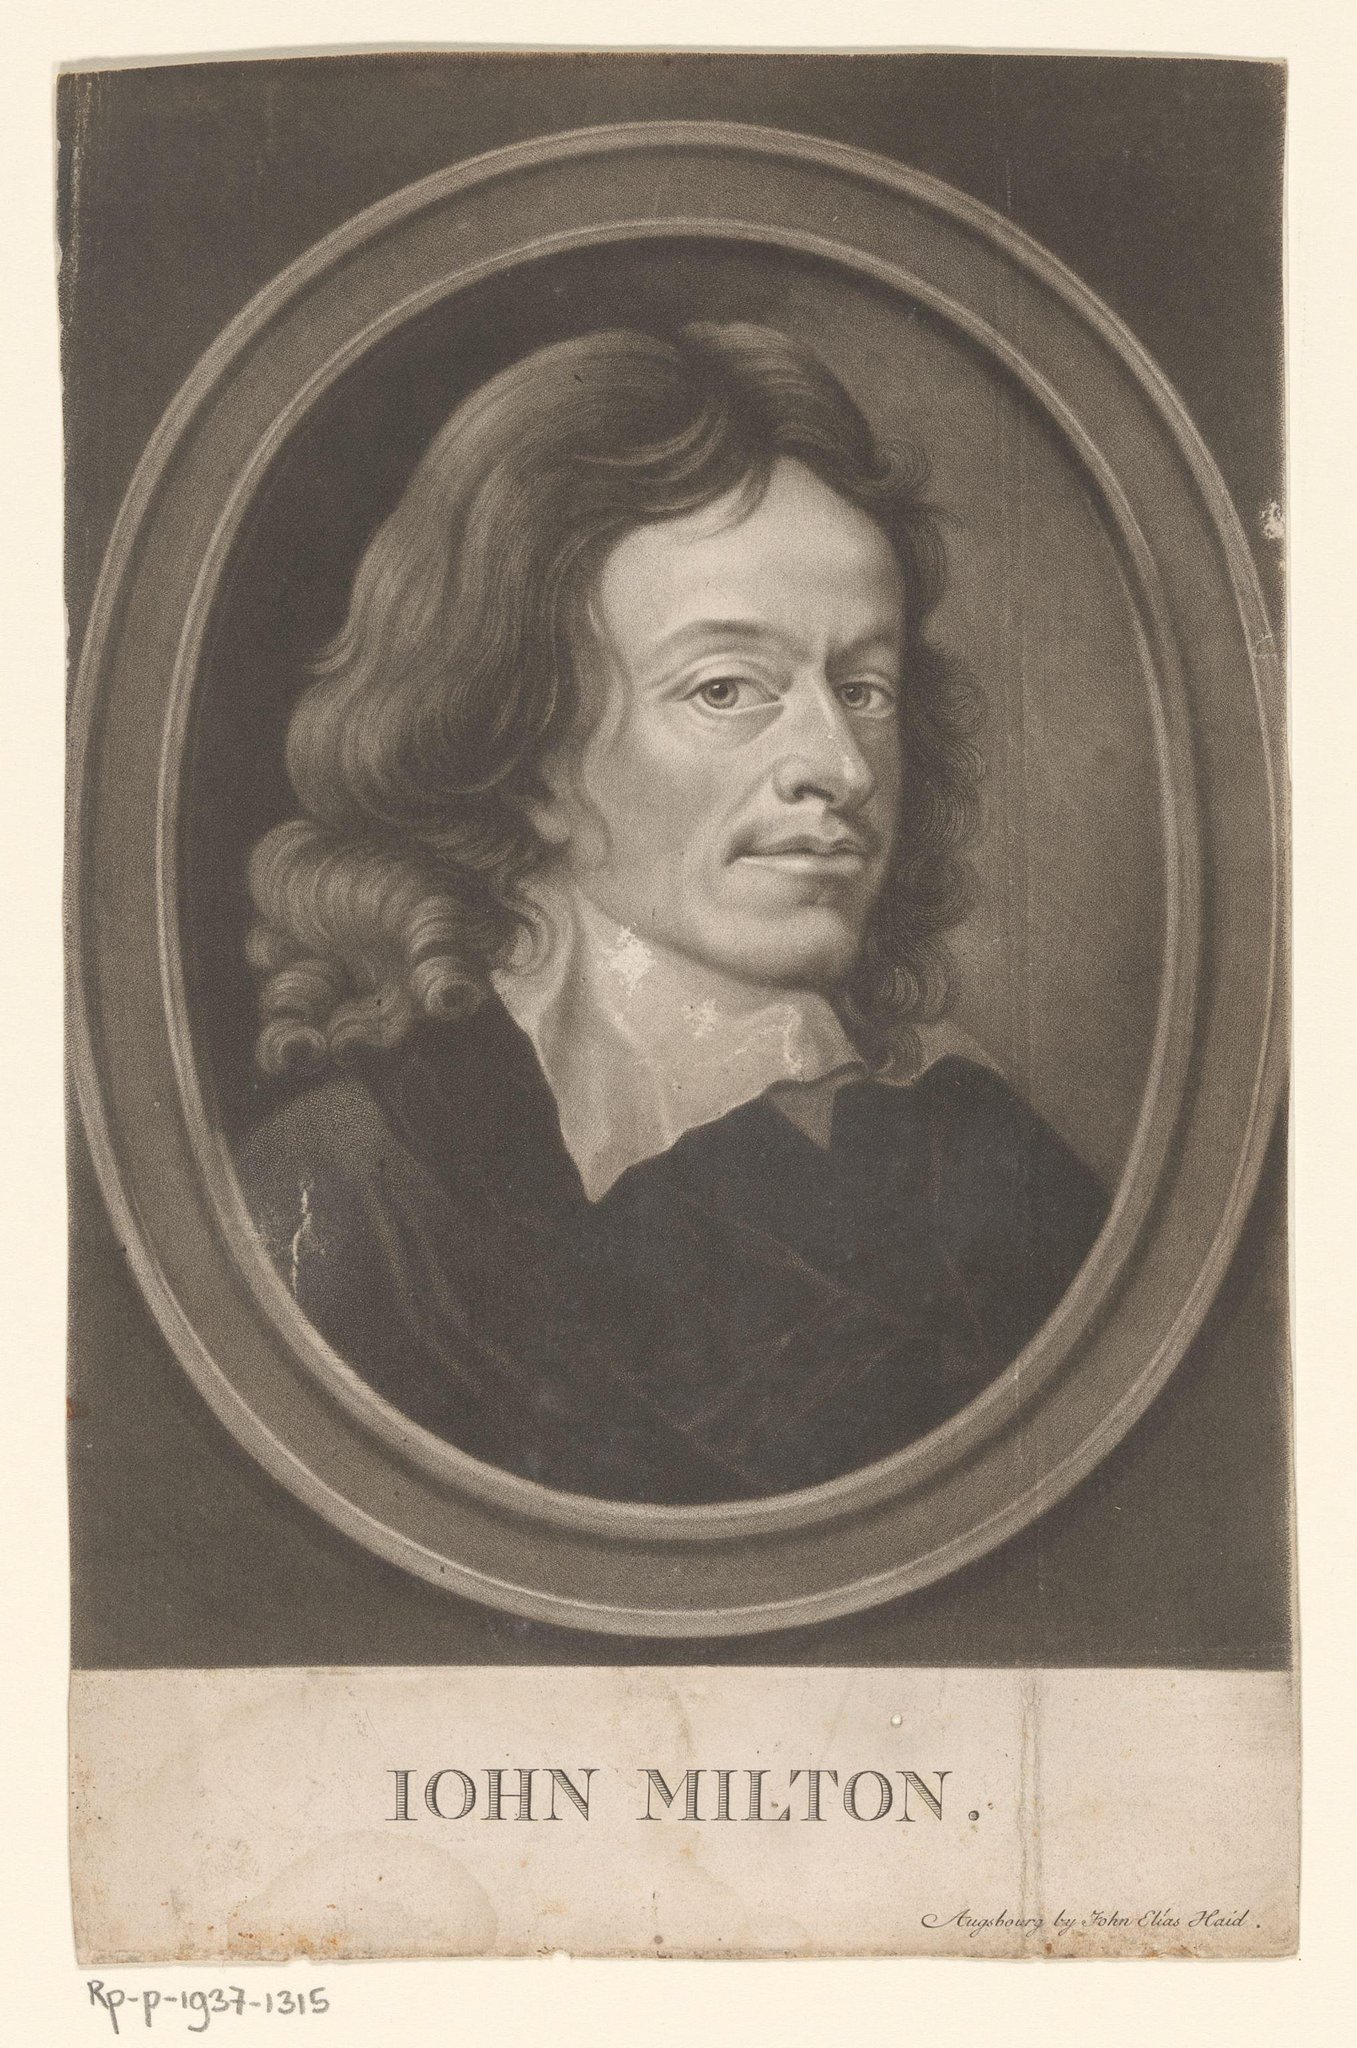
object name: print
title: Portret van John Hilton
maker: johann elias haid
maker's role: print maker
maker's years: 1739-1809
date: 1749-1809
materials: paper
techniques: mezzotint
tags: london, john milton, historical persons, writer, poet, author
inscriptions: collector's mark: Lugt 2228